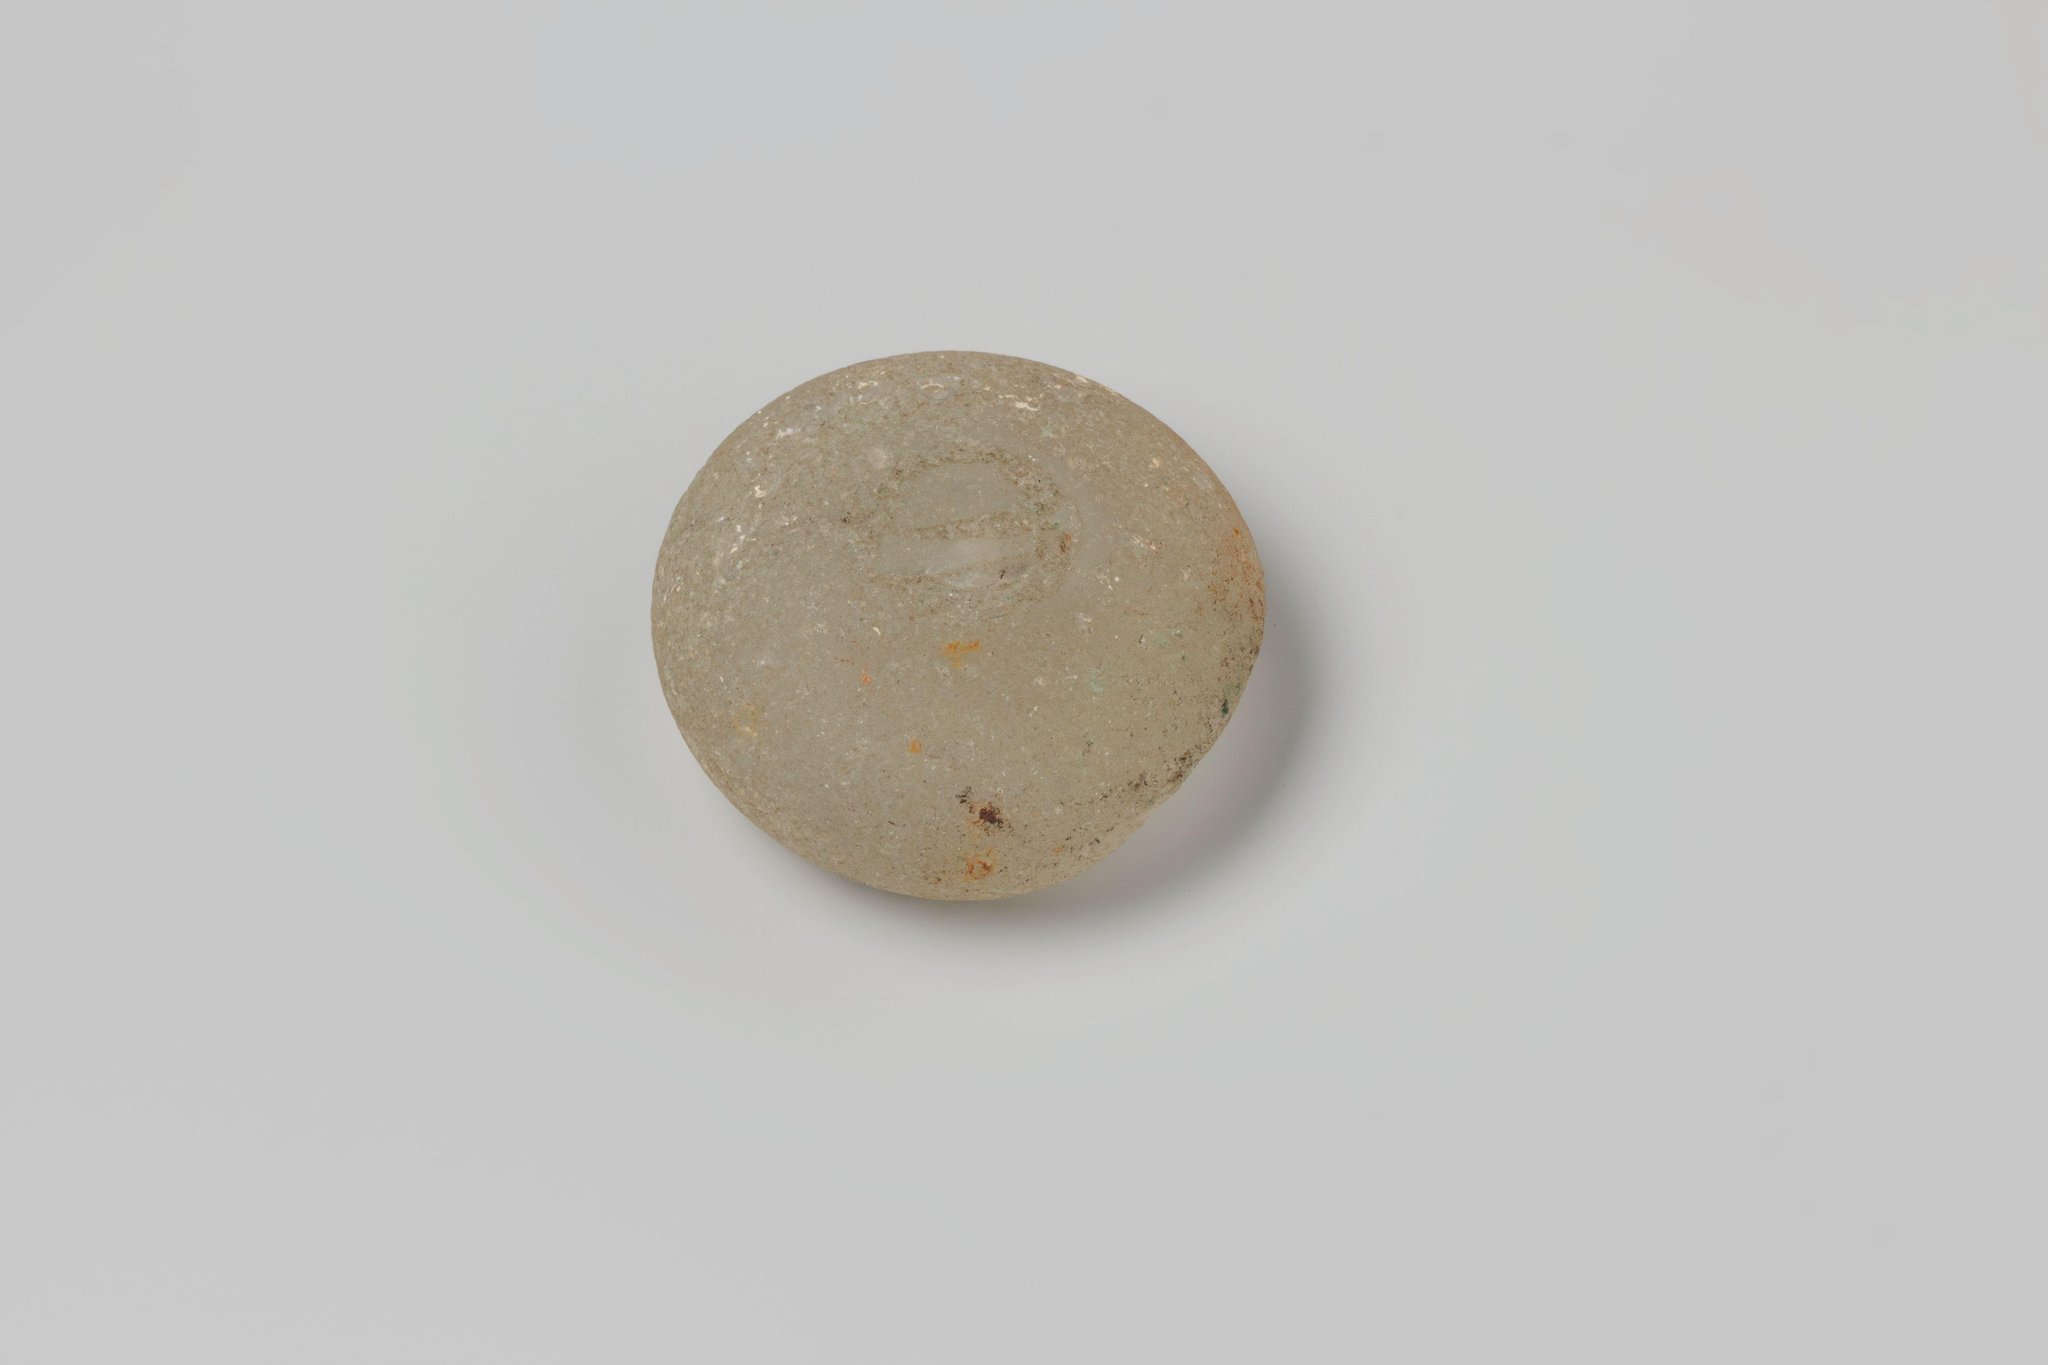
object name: vessel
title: Deksel van vaatwerk uit het wrak van de Oost-Indiëvaarder Hollandia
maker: Anonymous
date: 1700-1743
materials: glass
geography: netherlands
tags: verenigde oostindische compagnie, hollandia (schip), annet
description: Vessel part, lid; fragm, circular, slightly domed, central finial broken off, circular convex recess underneath.